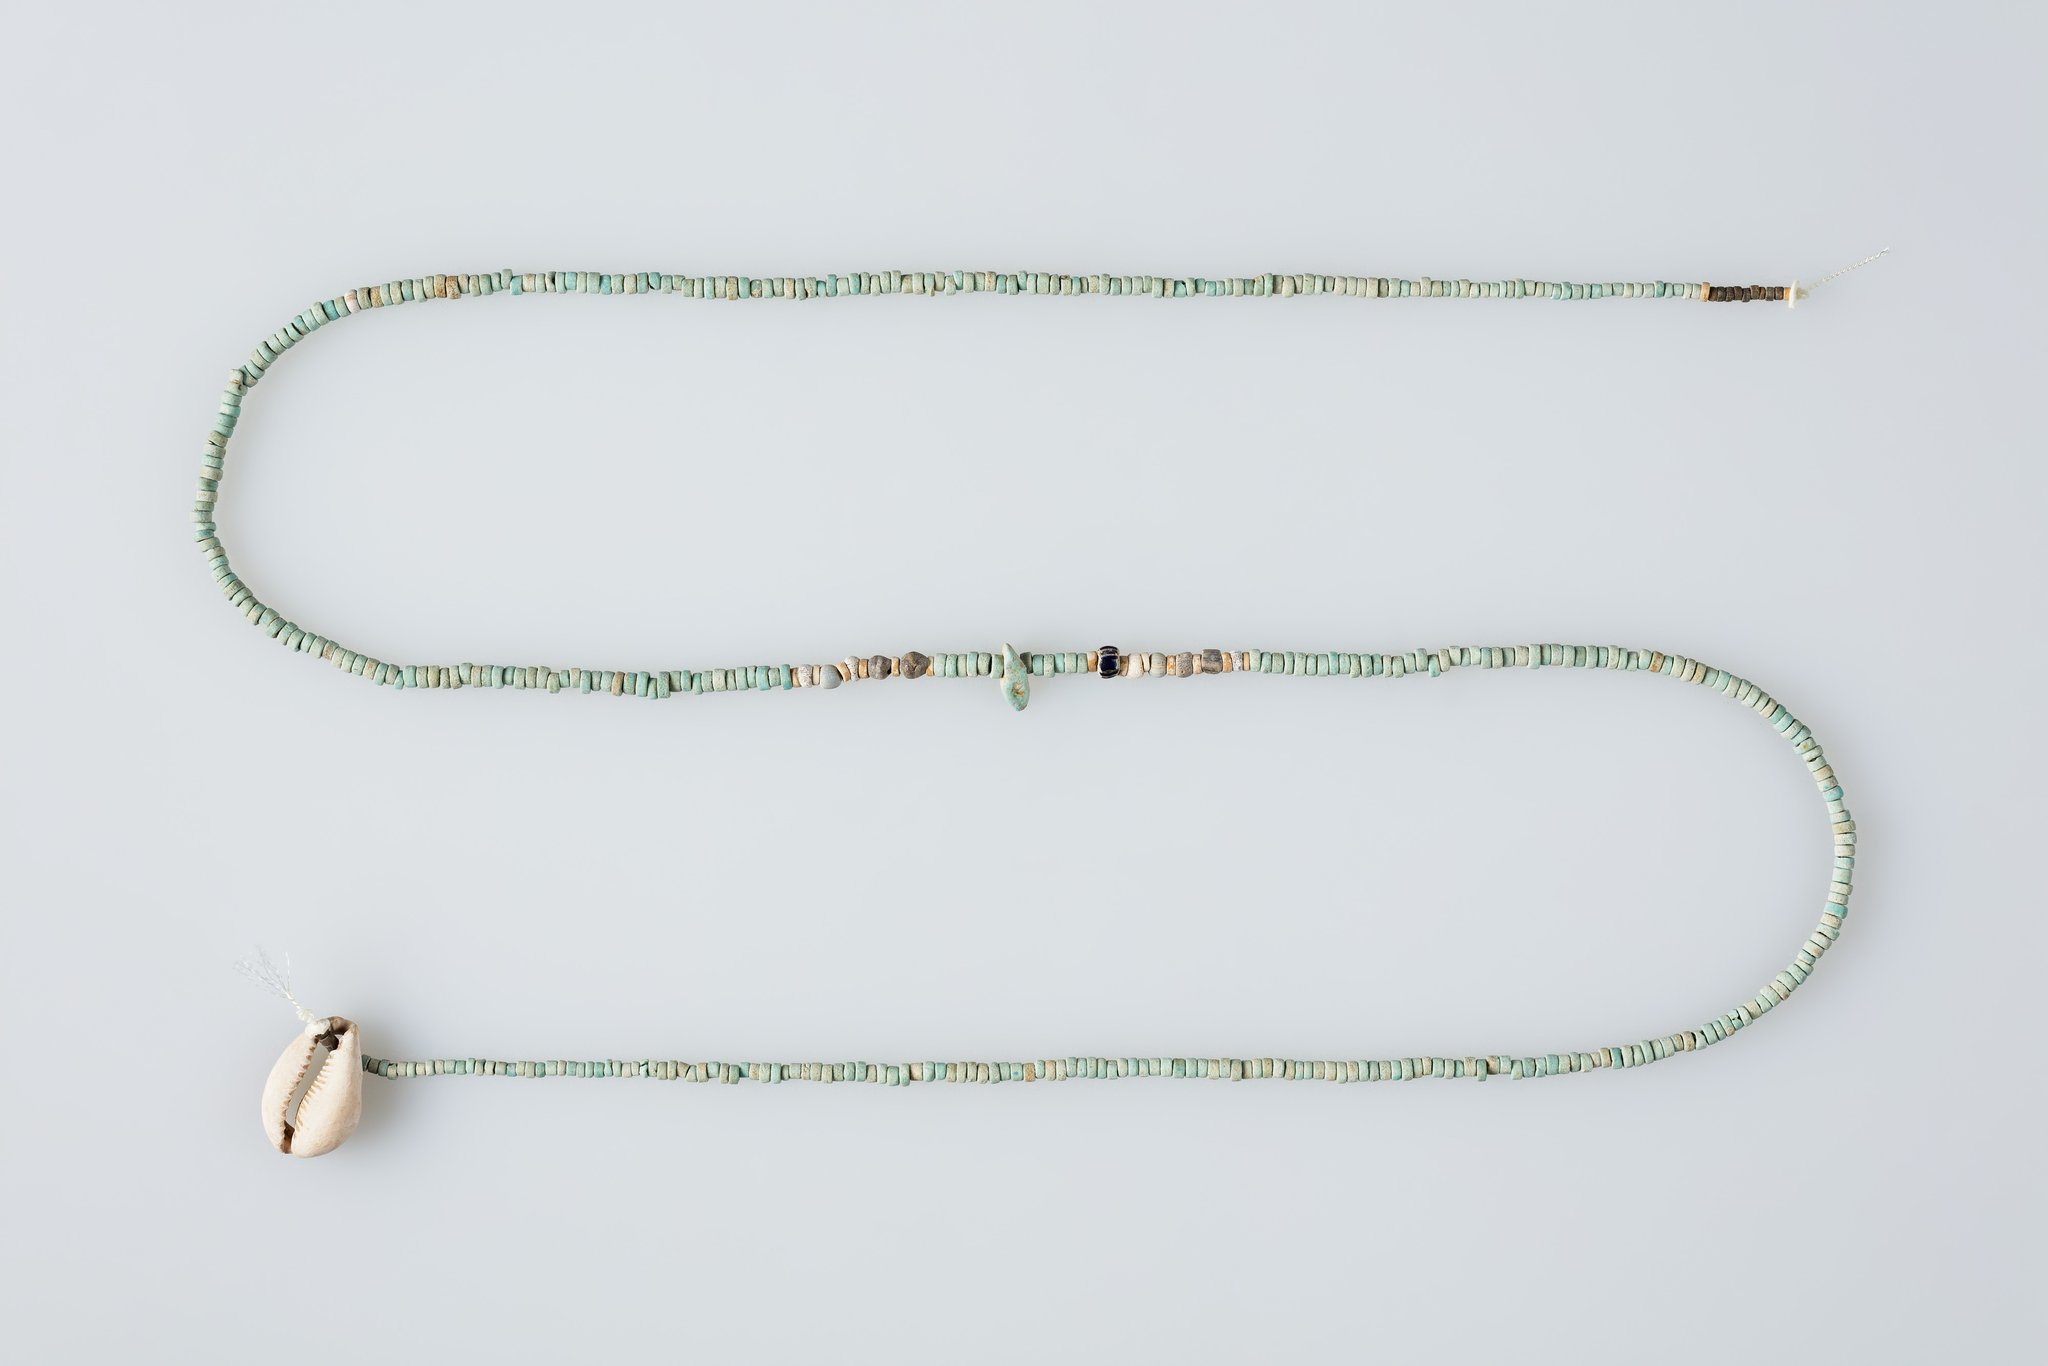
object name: bead, string, shell pendant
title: String of beads with shell pendant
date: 30 BCE-364 CE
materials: faience, shell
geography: nubia